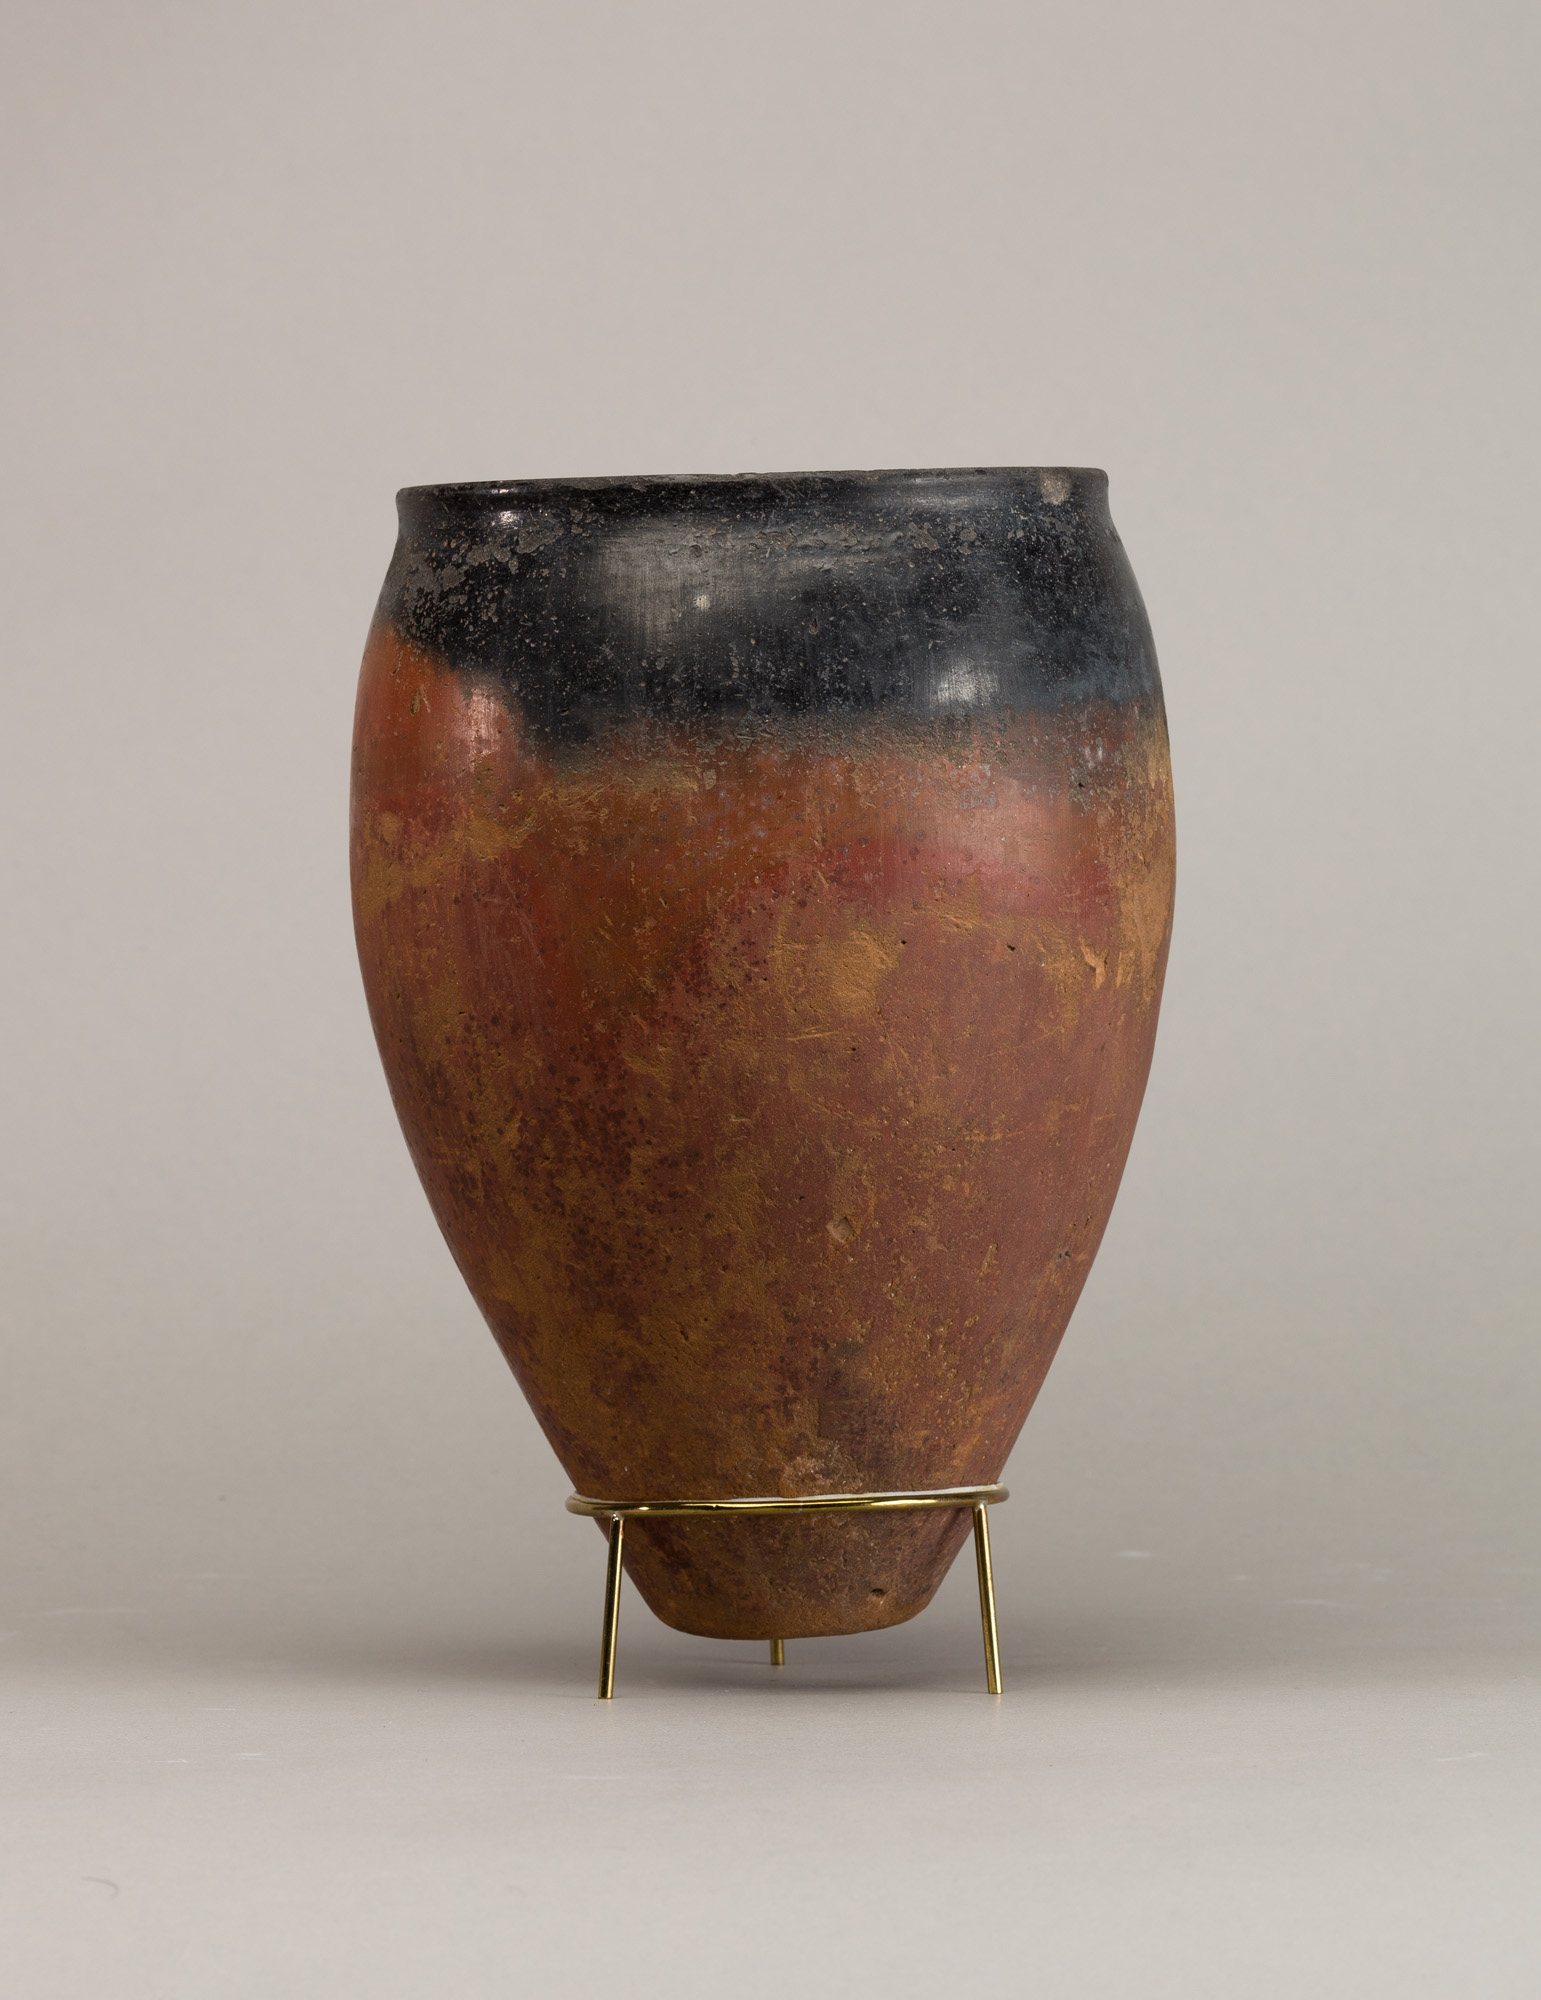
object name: jar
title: Black-topped red ware jar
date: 3850-2960 BCE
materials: pottery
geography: egypt